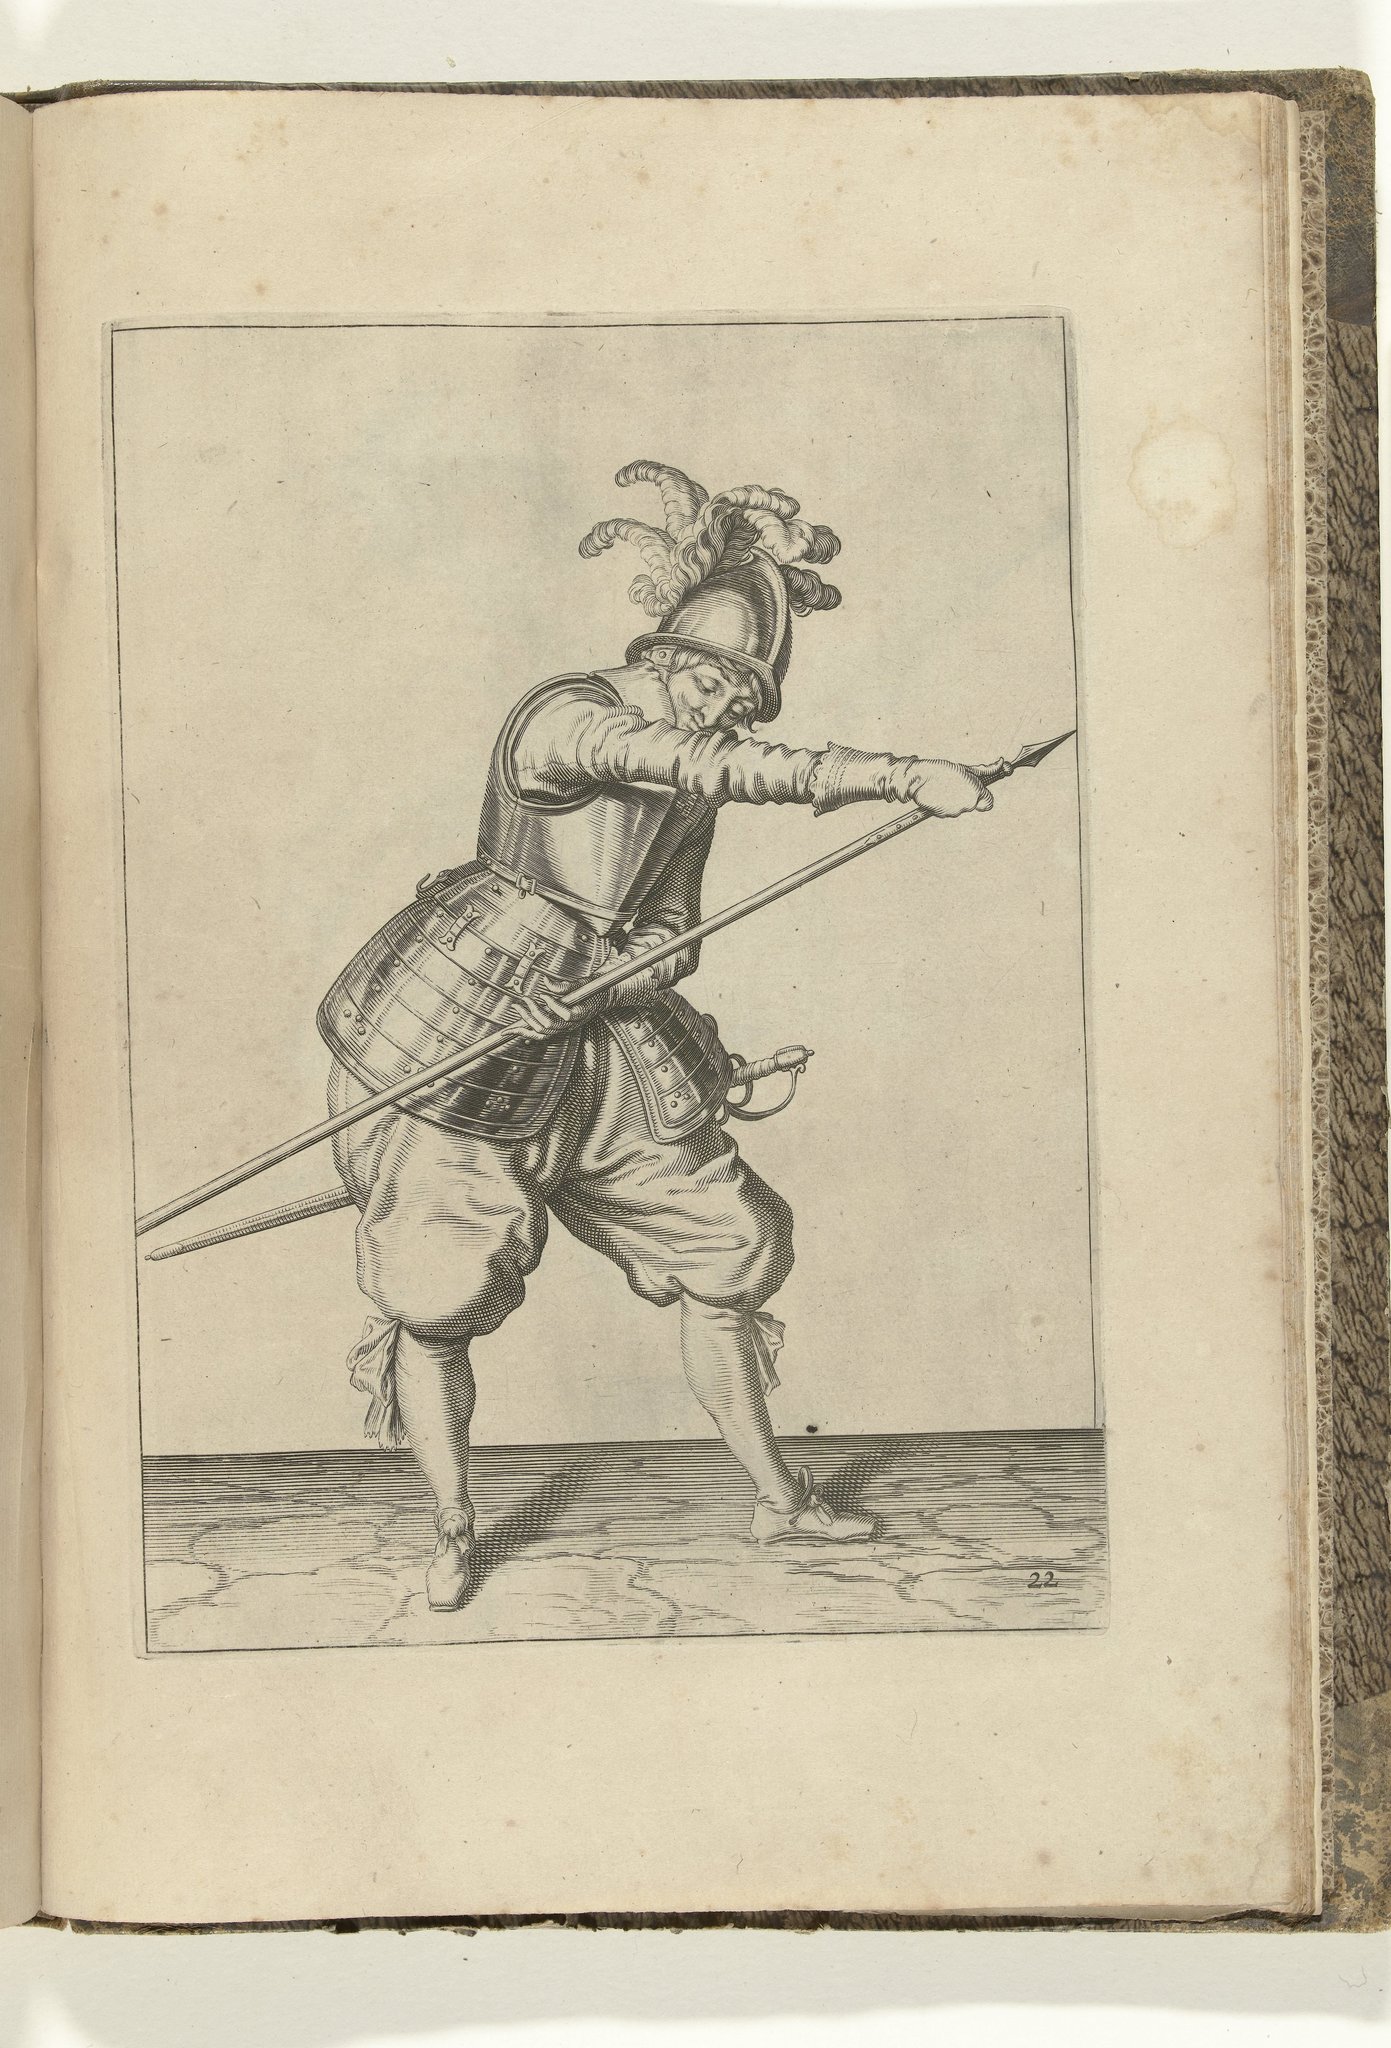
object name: print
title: Soldaat die met zijn rechterhand de punt van zijn spies naar voren steekt en met zijn linkerhand de schacht vastpakt (nr. 22), ca. 1600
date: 1597-1608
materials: paper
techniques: engraving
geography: amsterdam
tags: the hague, maurice (prince of orange), handling of weapons ~ military training, weapons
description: Een soldaat, ten voeten uit, naar rechts, die met zijn rechterhand de punt van zijn spies (lans) naar voren steekt en met zijn linkerhand de schacht vastpakt (nr. 22), ca. 1600. Plaat 22 in de instructies voor het hanteren van de spies: Enseignement brief; et succint sur les portraitz figurez, touchant l'usage, de tout ce qu'un Soldat doibt faire au maniement de la Pique. Onderdeel van de illustraties in een Franse editie van J. de Gheyns Wapenhandelinghe: J. de Gheyn, Maniement d'armes, d'arquebuses, mousquetz et piques : en conformité de l'ordre de Mour le Prince Maurice, Prince d'Orange, Amsterdam 1608. Krijgswezen rond 1600.